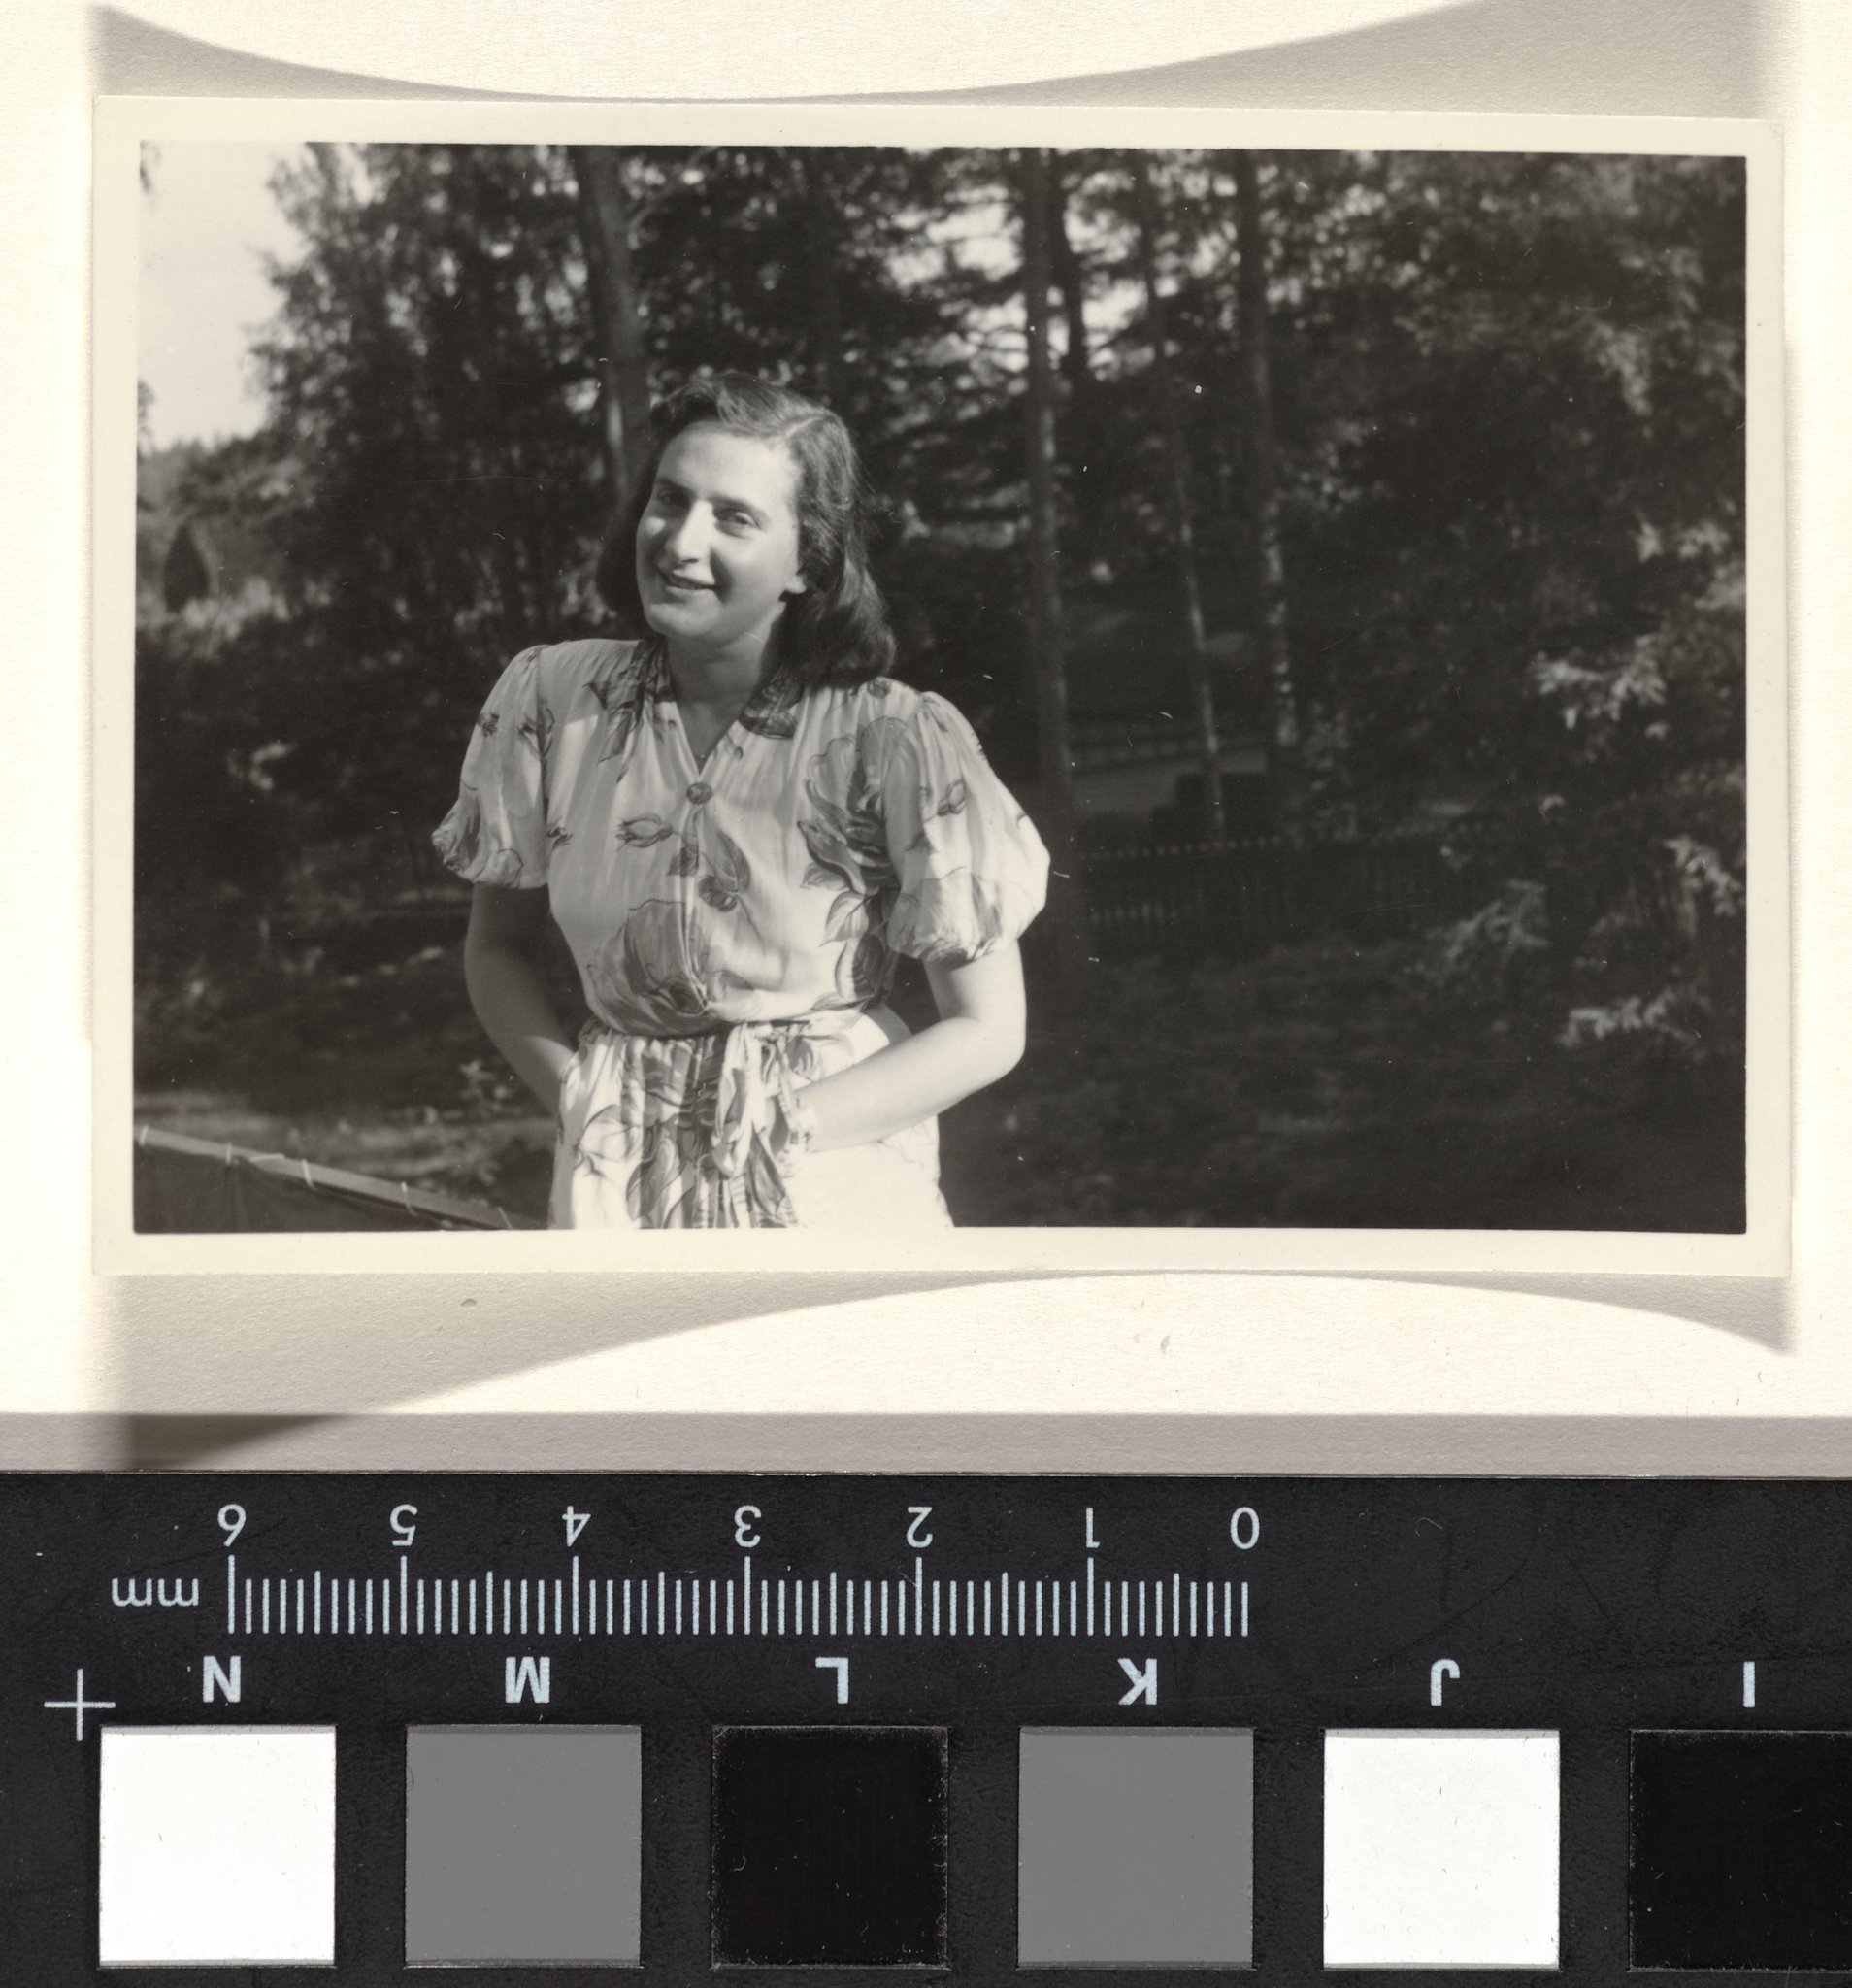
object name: photograph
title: Isabel Wachenheimer in jurk met bloemenmotief en haar handen in zakken, staand voor een bos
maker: Anonymous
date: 1945-1956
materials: photographic support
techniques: gelatin silver print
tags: leiden, isabel wachenheimer-elon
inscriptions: number: ‘2/11’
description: Isabel Wachenheimer in jurk met bloemenmotief en haar handen in zakken, staand voor een bos.